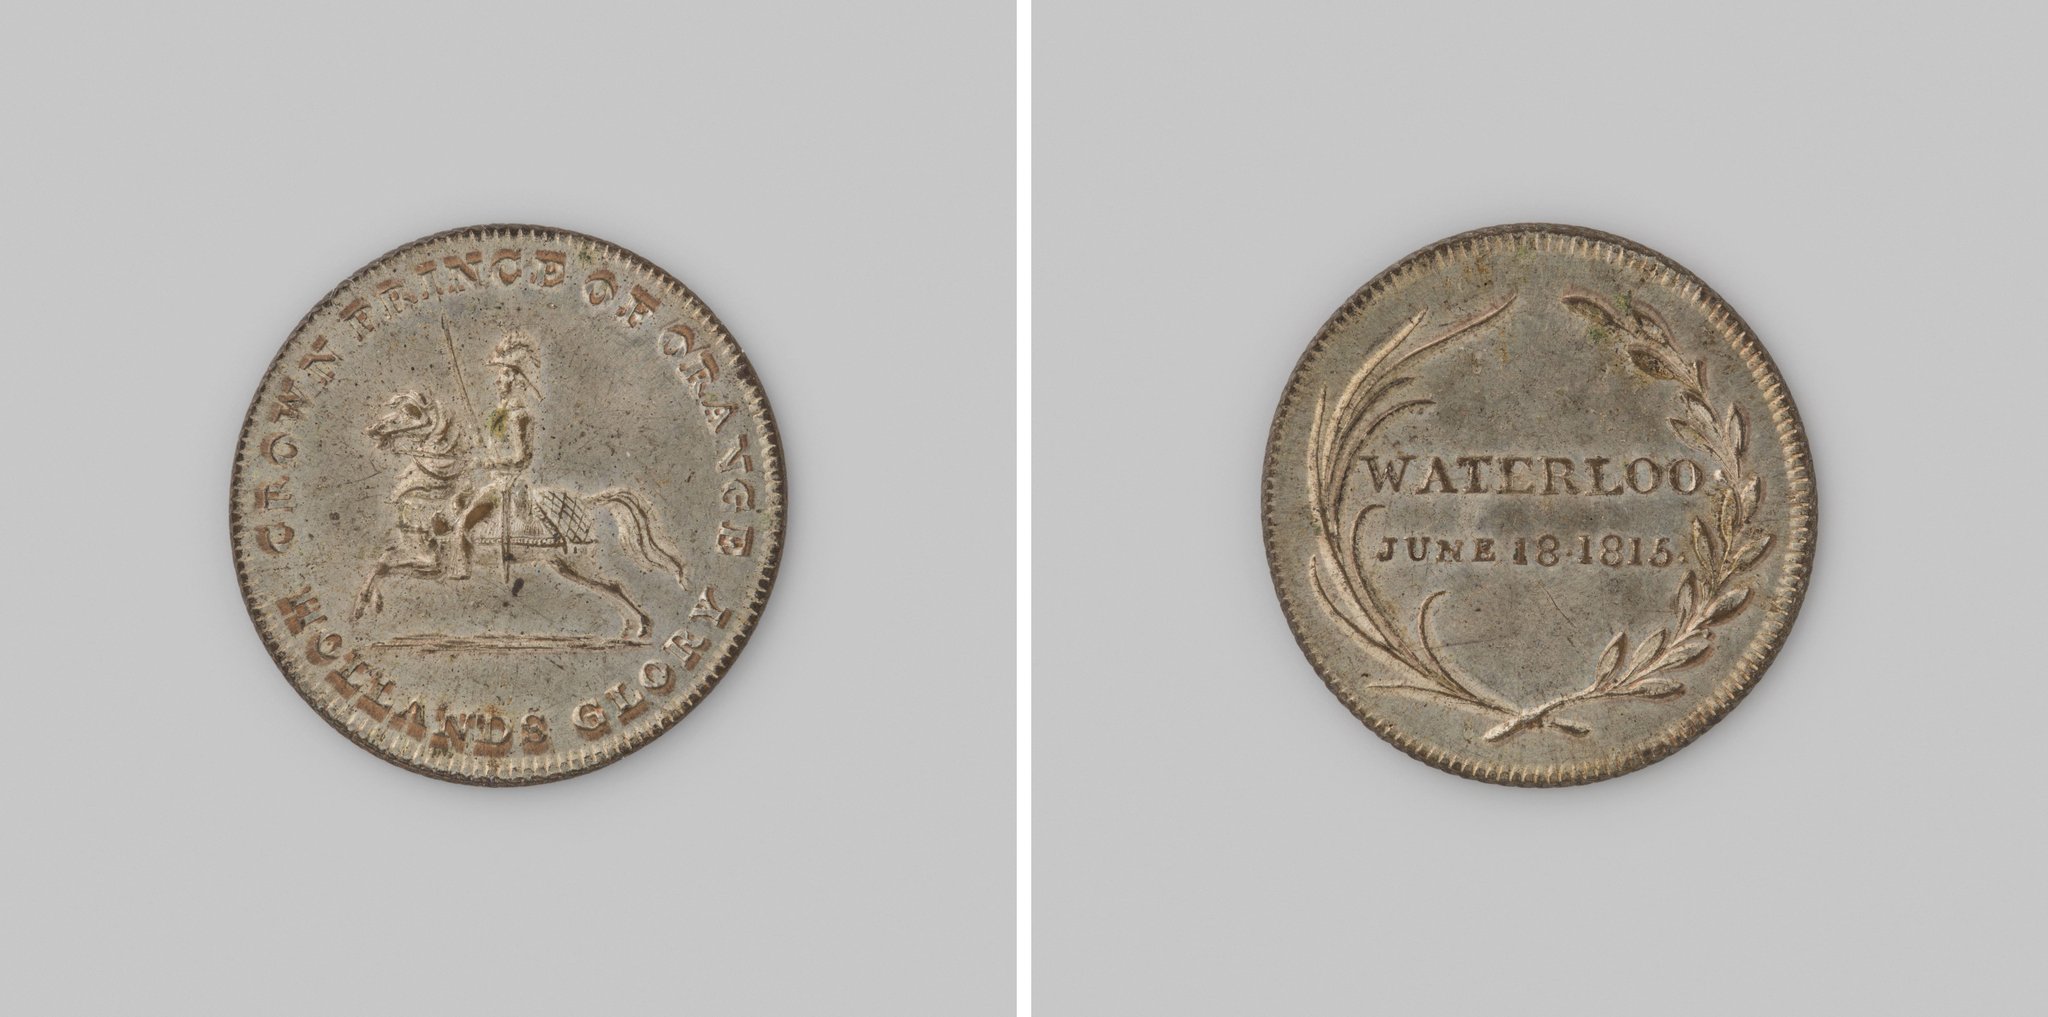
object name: history medal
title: De Kroonprins van Oranje in de Slag bij Waterloo 1815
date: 1815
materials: brass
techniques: striking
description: Verzilverde penning, op de voorzijde de kroonprins met blanke sabel te paard naar links, met omschrift, op de keerzijde twee regels tekst tussen palm- en lauwertak, Engelstalig.